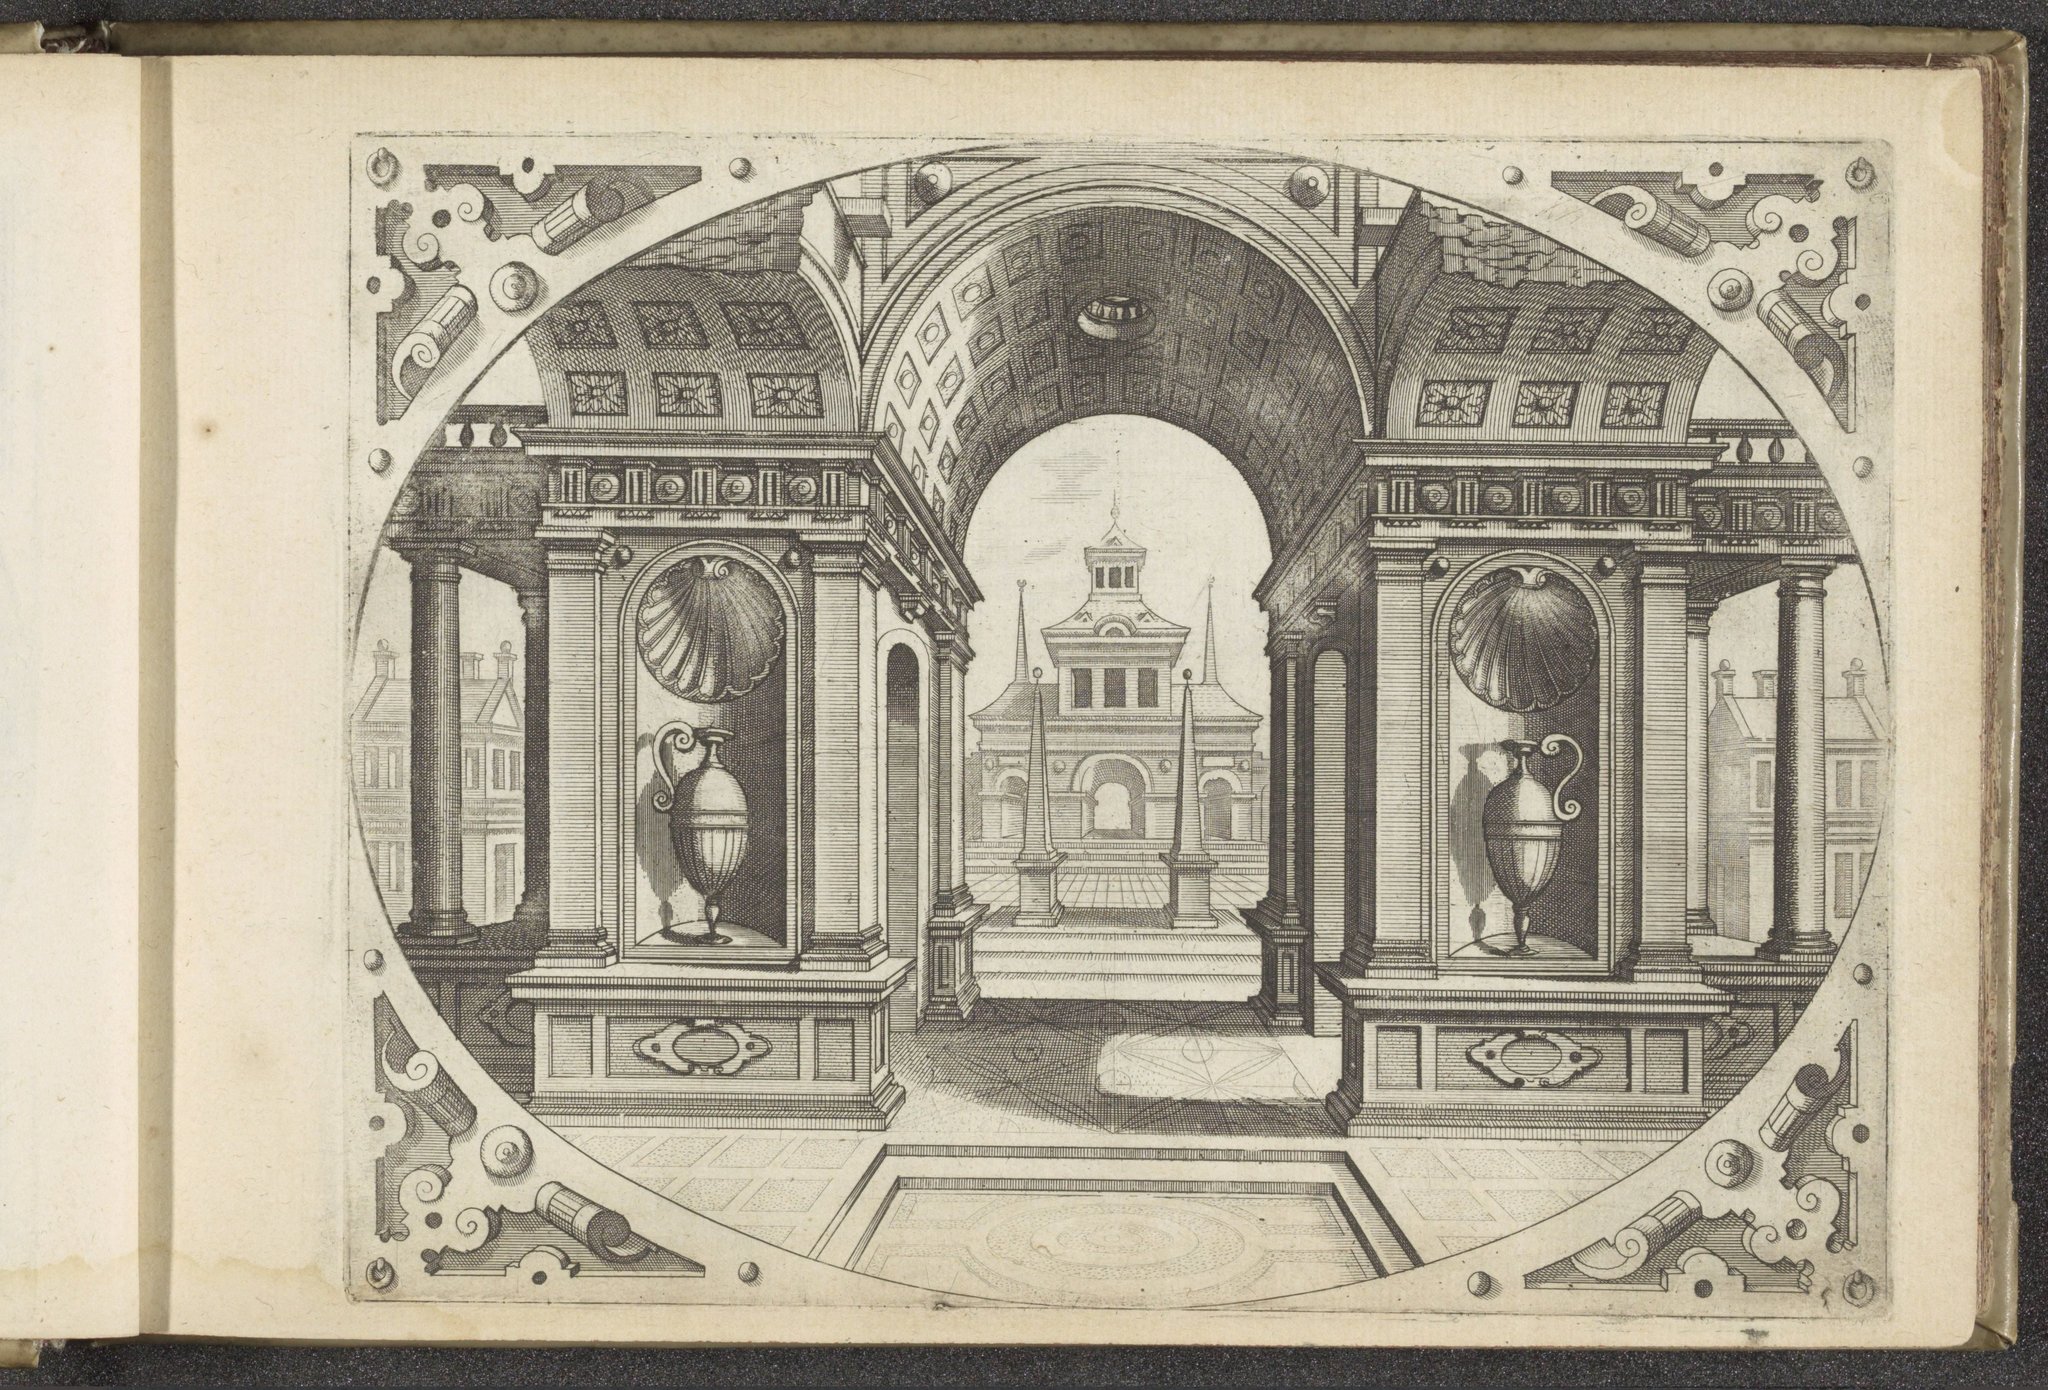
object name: album leaf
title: Deel van een portaal met vazen in nissen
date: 1560-1562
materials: paper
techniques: etching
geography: antwerp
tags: architectural representations in general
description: Deel van een portaal met vazen in nissen. Door de poort een gezicht op twee obelisken voor een stadspoort. In de hoeken rolwerk. Deze prent maakt deel uit van een album.